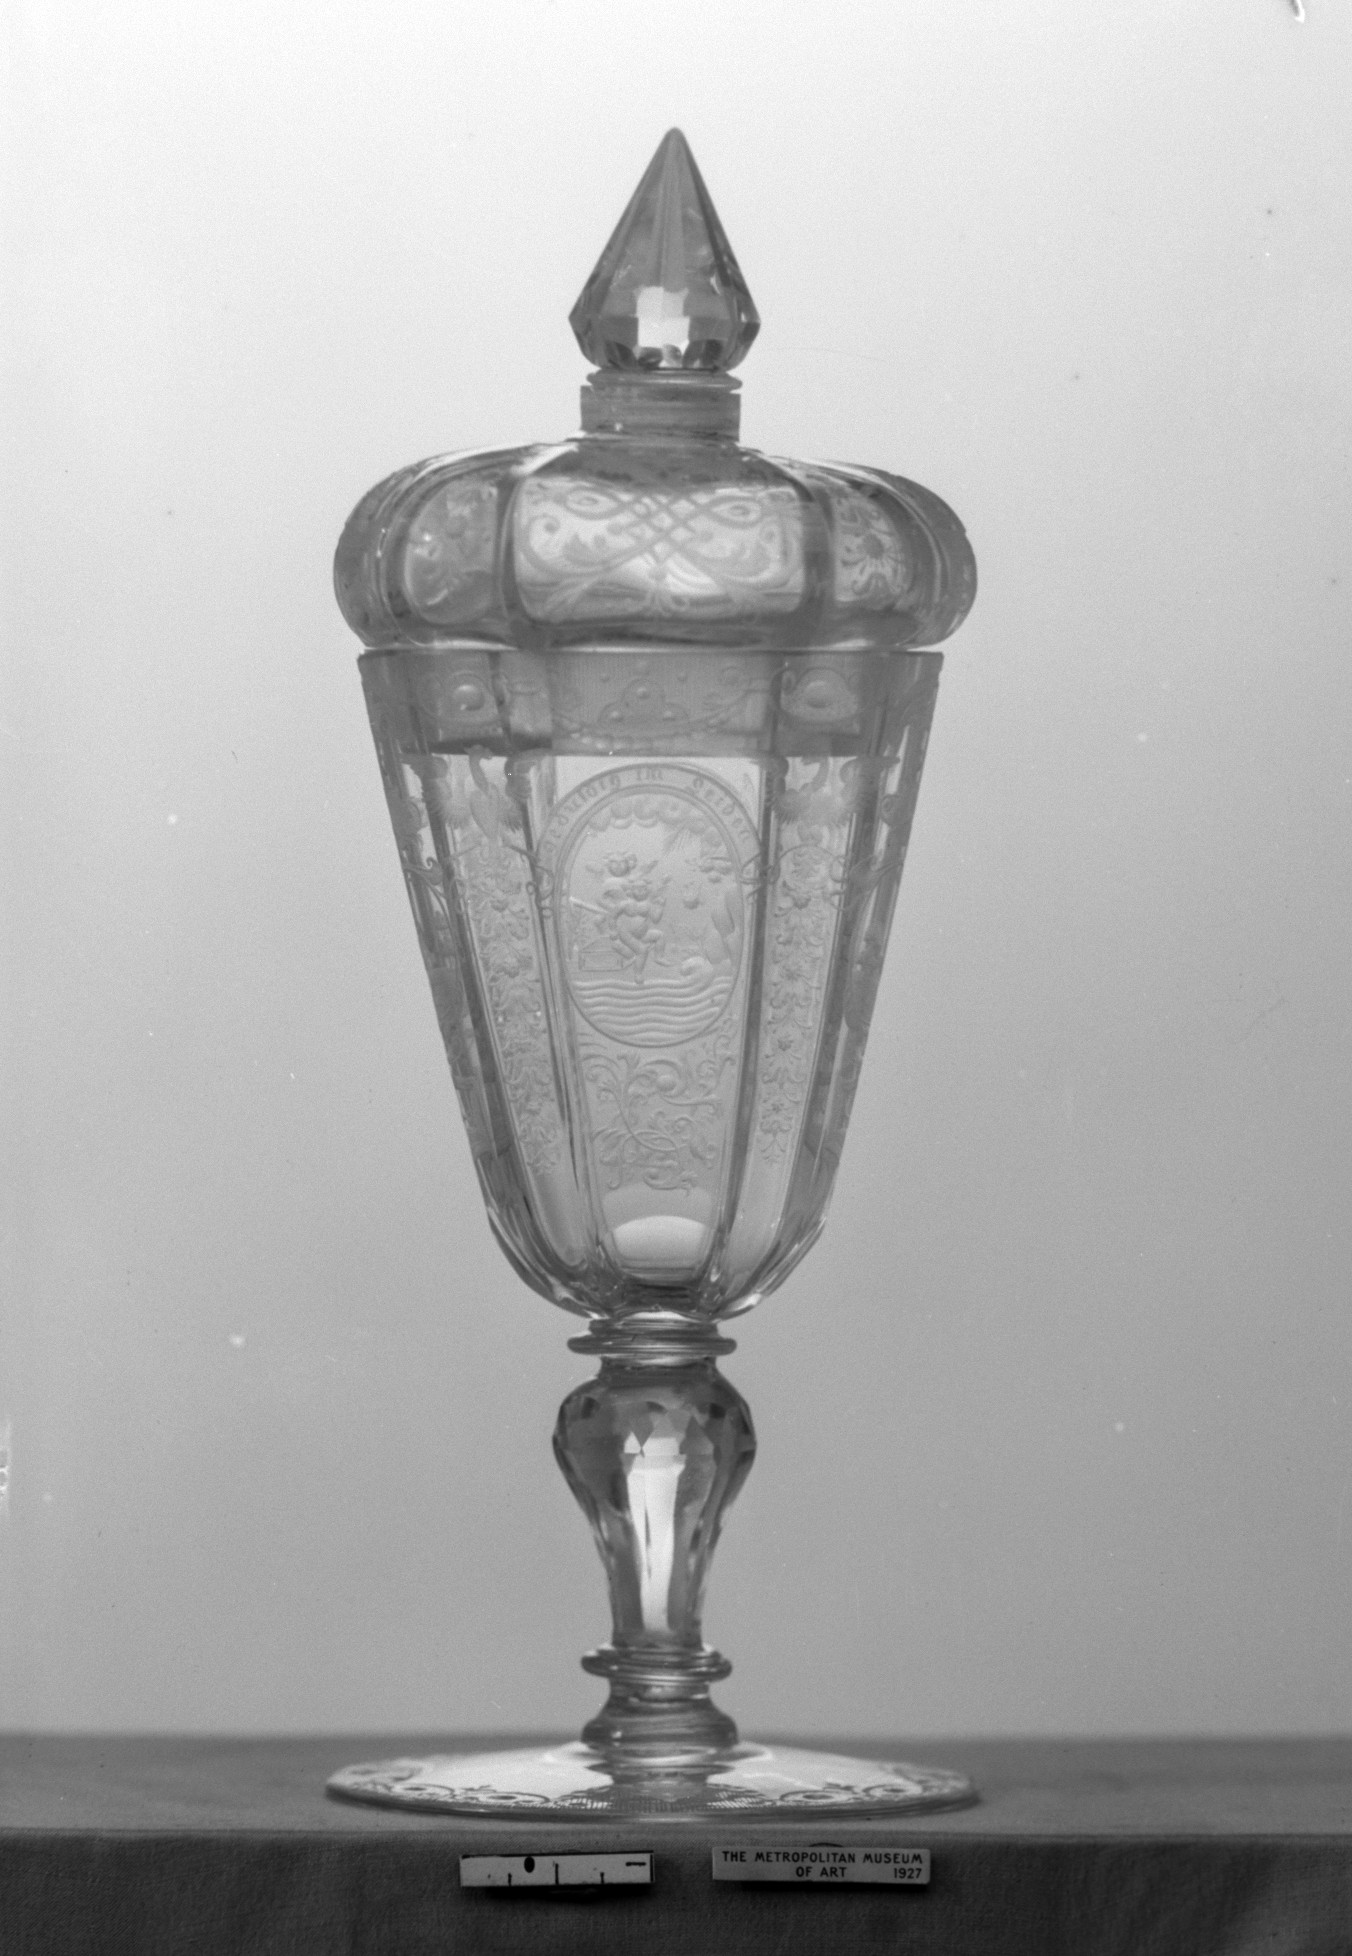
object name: standing cup with cover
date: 1720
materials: glass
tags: human figures,coat of arms